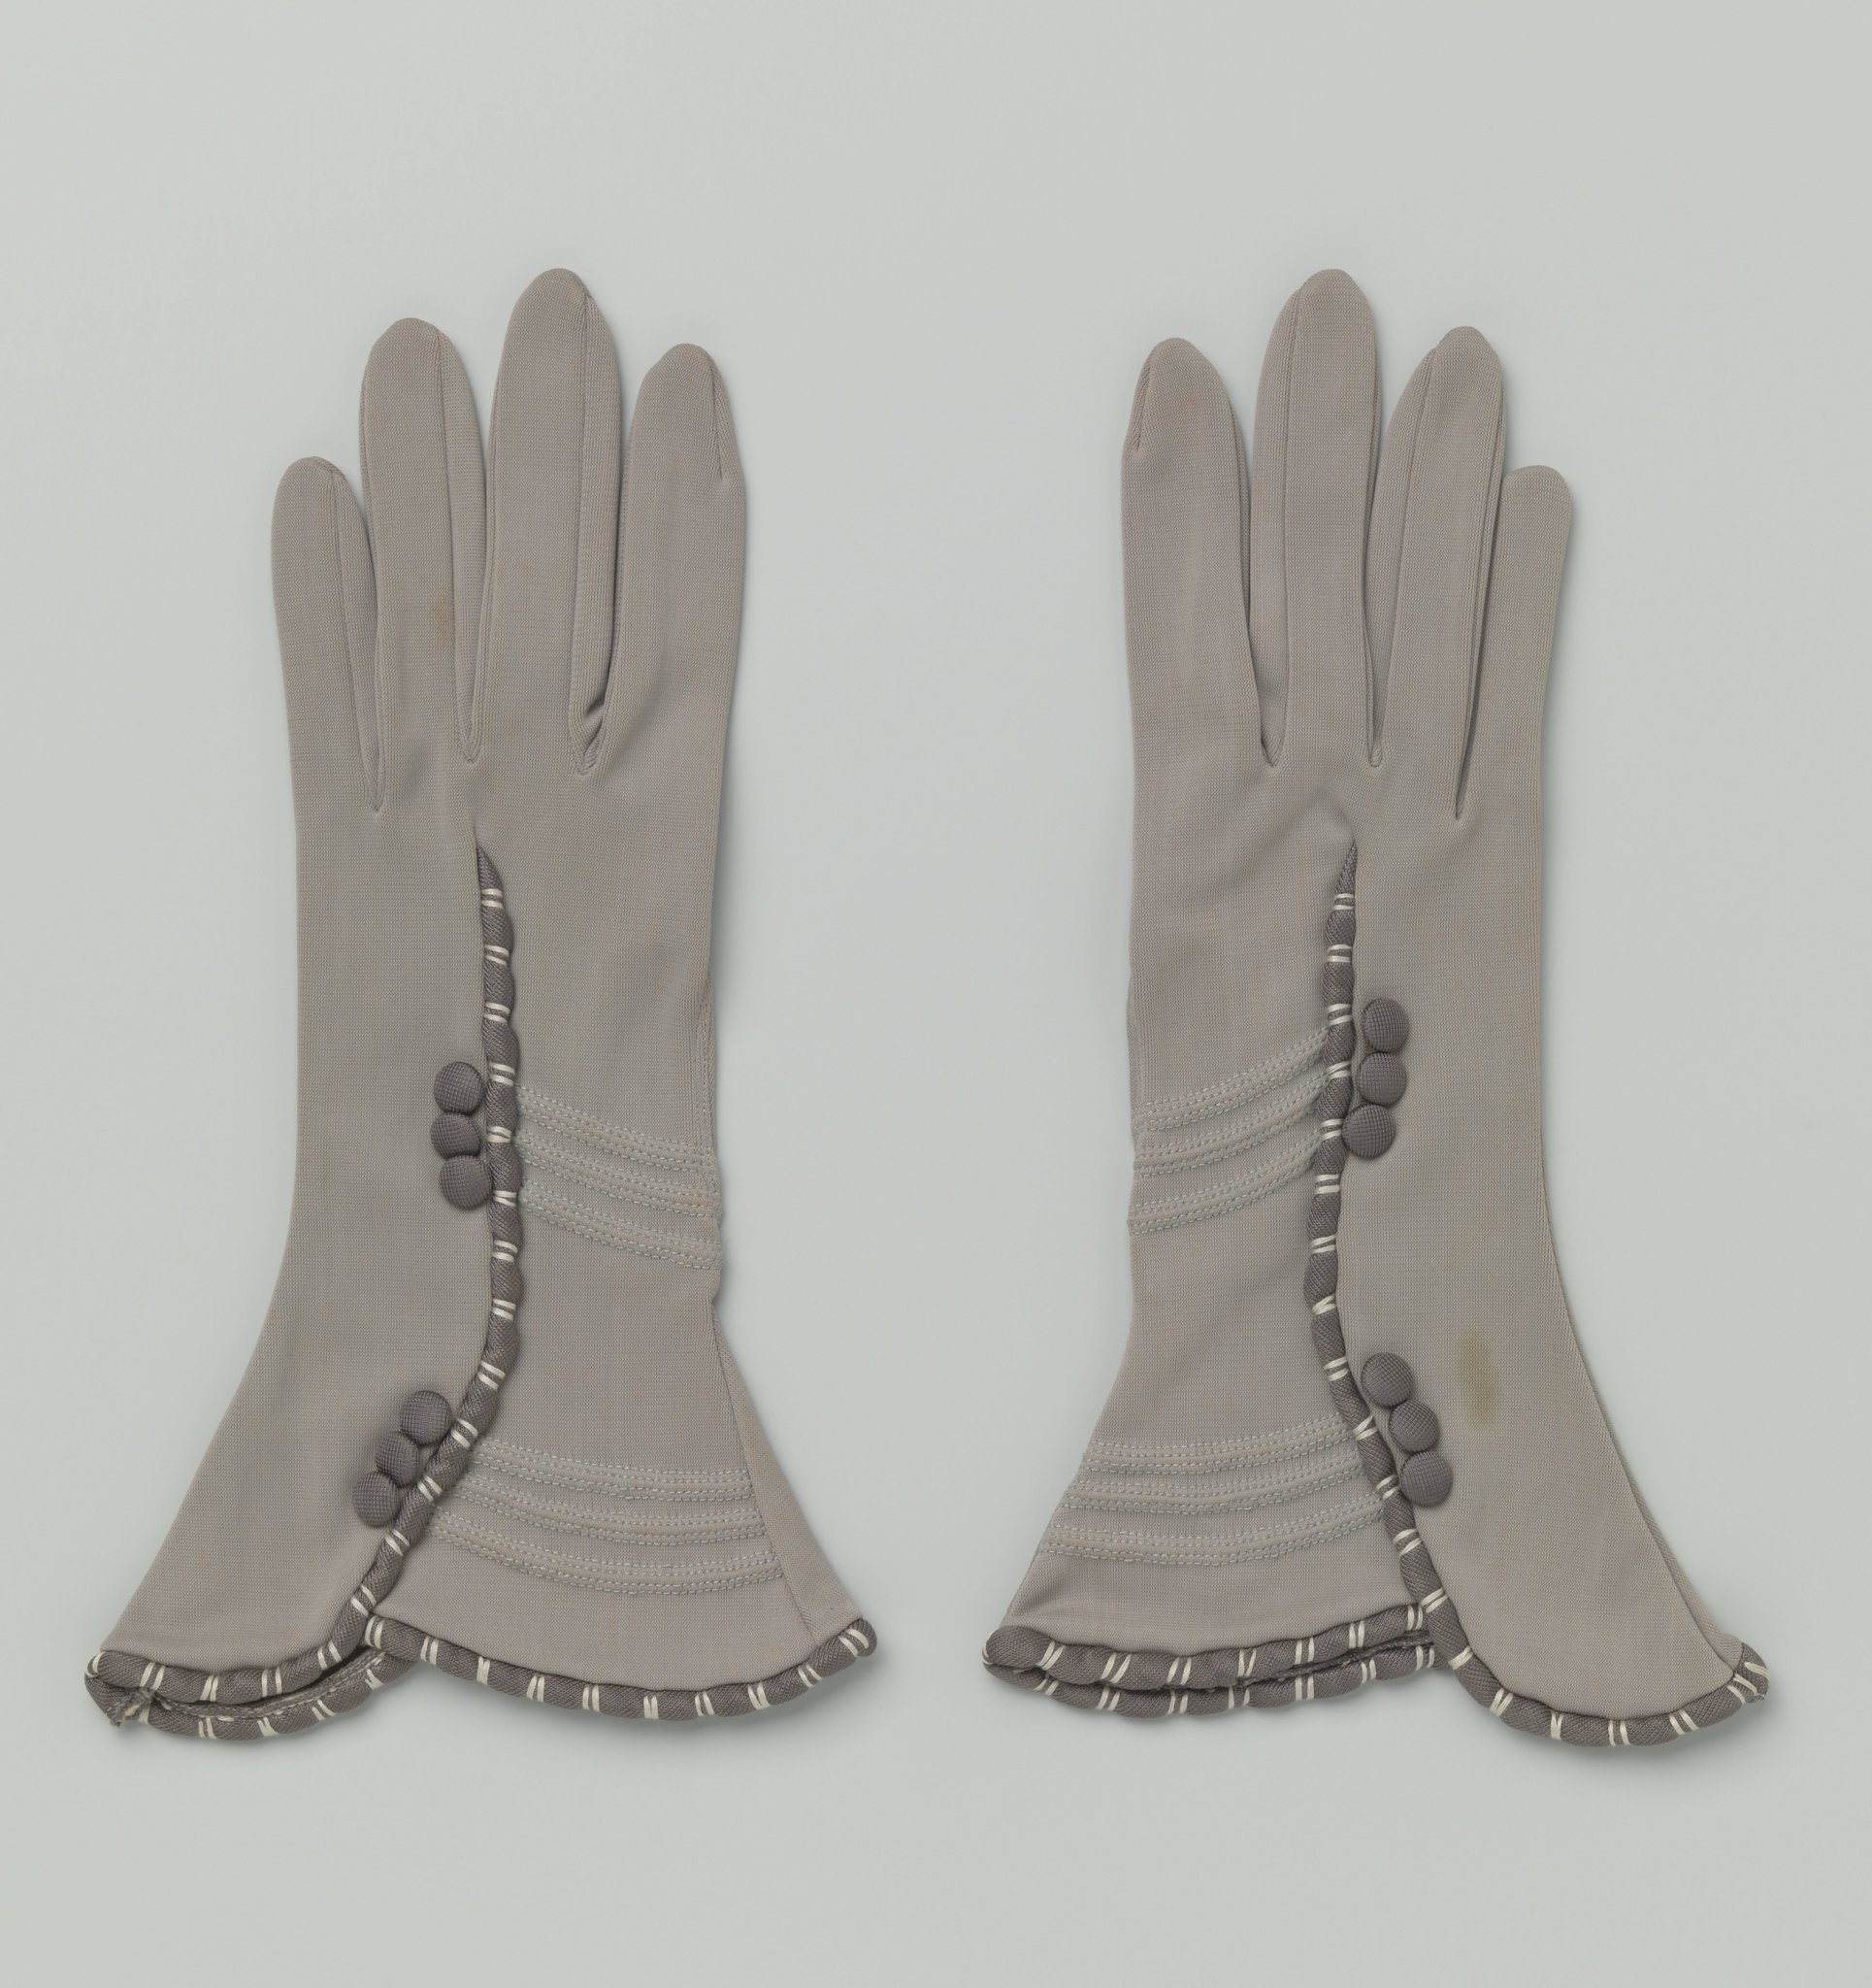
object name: womenswear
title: Pair of gloves with cut-on cuffs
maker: Anonymous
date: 1950-1960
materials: plastic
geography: western europe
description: Rechter handschoenen van muisgrijs nylon. Aangeknipte waaiervormige kappen. Op de hand een halfronde uitlopende naat waarin een opgevulde band (rouleaux) anthracietkleurig nylon is bevestigd. Deze band, met witte lussen in kleine vakken verdeelt, loopt verder langs de rand van de kap. Op de hand en bij de pols bevinden zich aan de ene kant naast de band drie anthraciet nylon knoopjes en aan de andere kant drie opgevulde, doorgestikte banden.